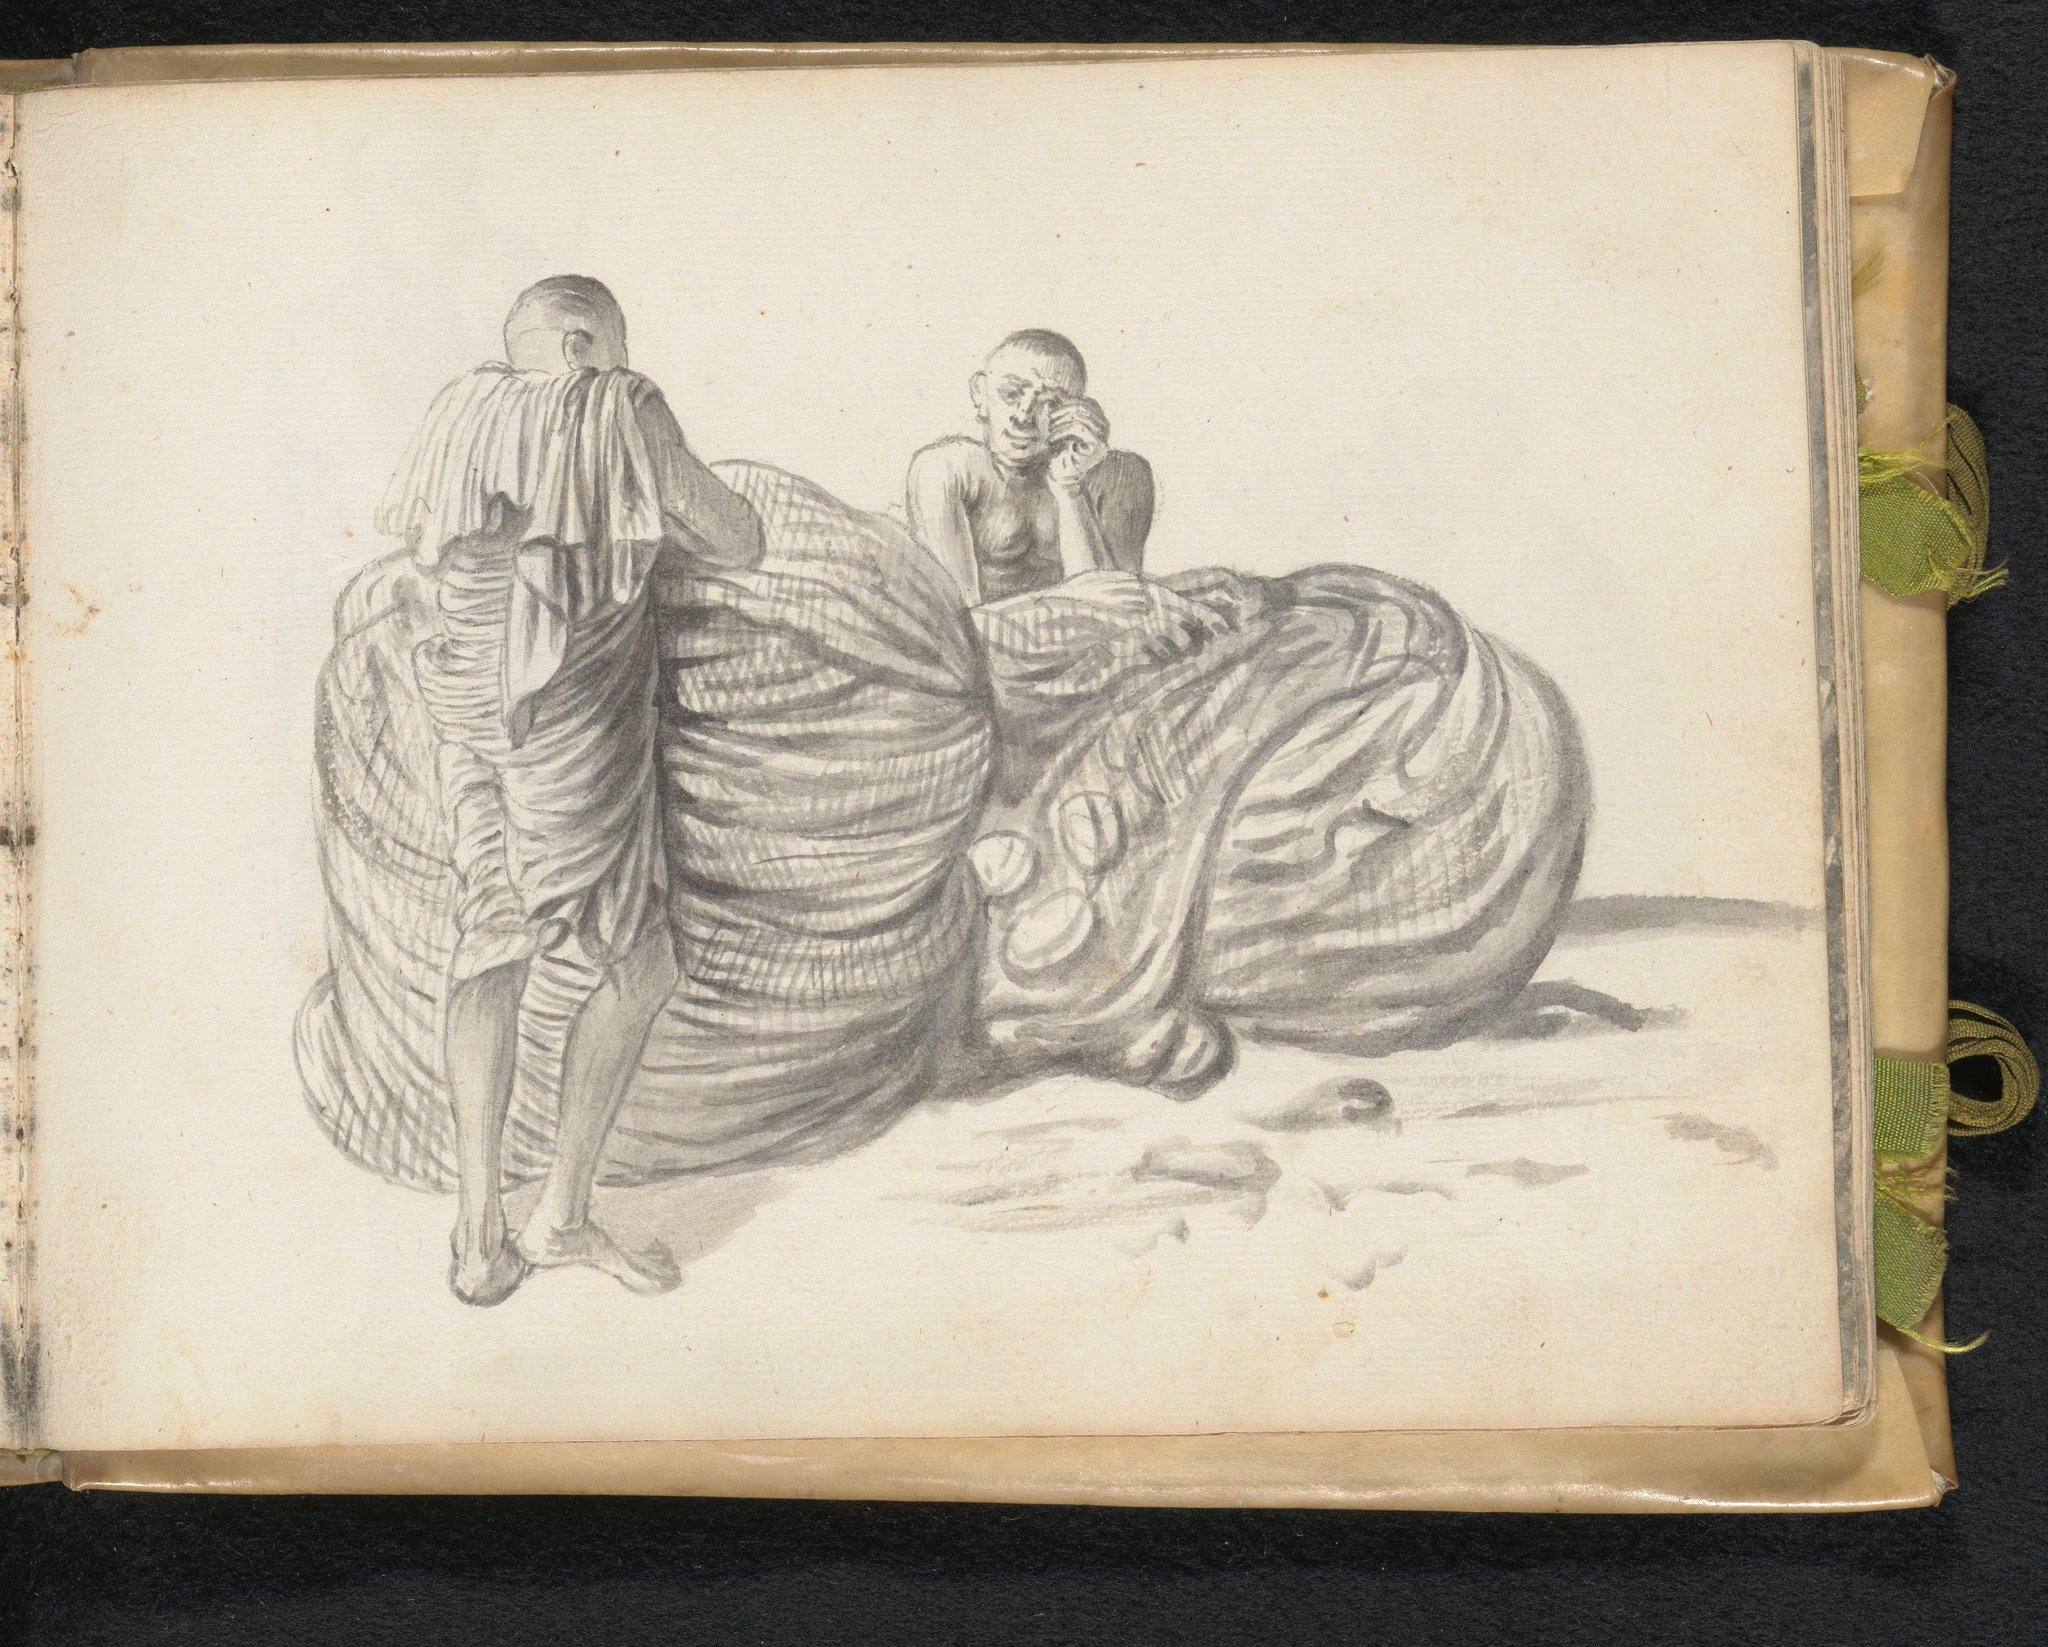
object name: sketchbook leaf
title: Two fishermen and their rolled up fishing nets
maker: esaias boursse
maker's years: 1631-1672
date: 1662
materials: ink, paper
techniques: brush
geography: sri lanka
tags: asiatic races and peoples (srilankans), asiatic races and peoples (with name), skirt (dhoti), 41d232(...) skirt (lungi), head-gear (with name), sea and coastal fishery, sri lanka